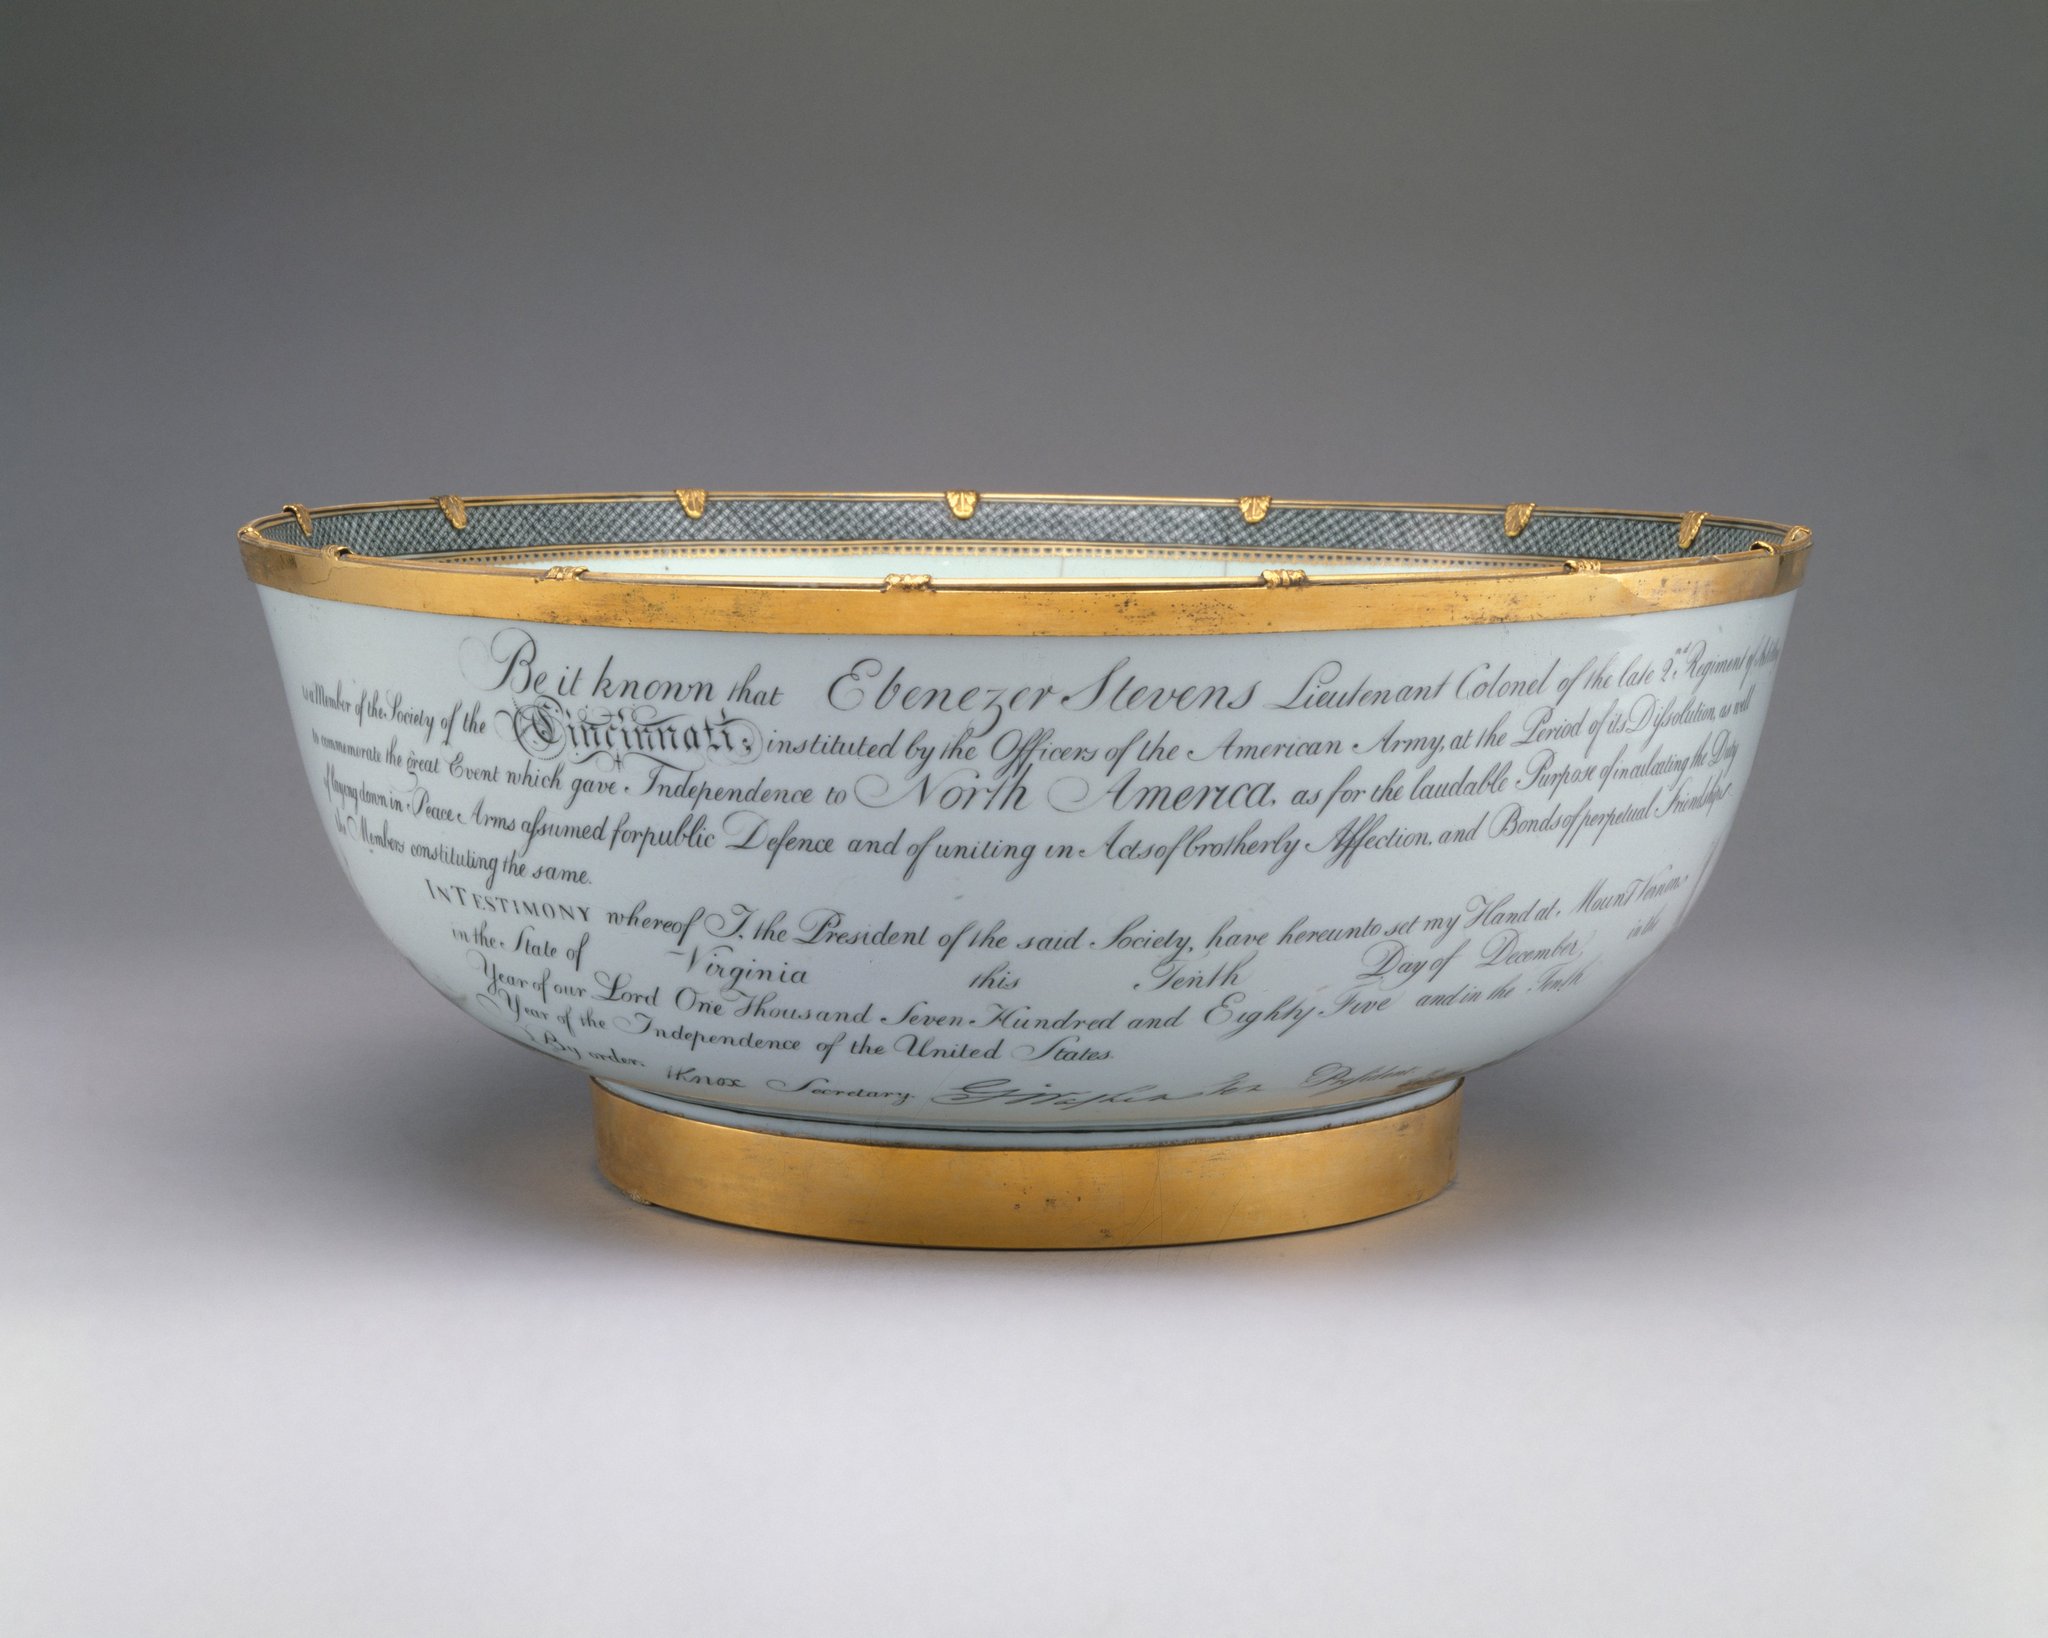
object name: punch bowl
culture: chinese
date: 1786-1790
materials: porcelain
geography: china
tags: eagles,lions,ships